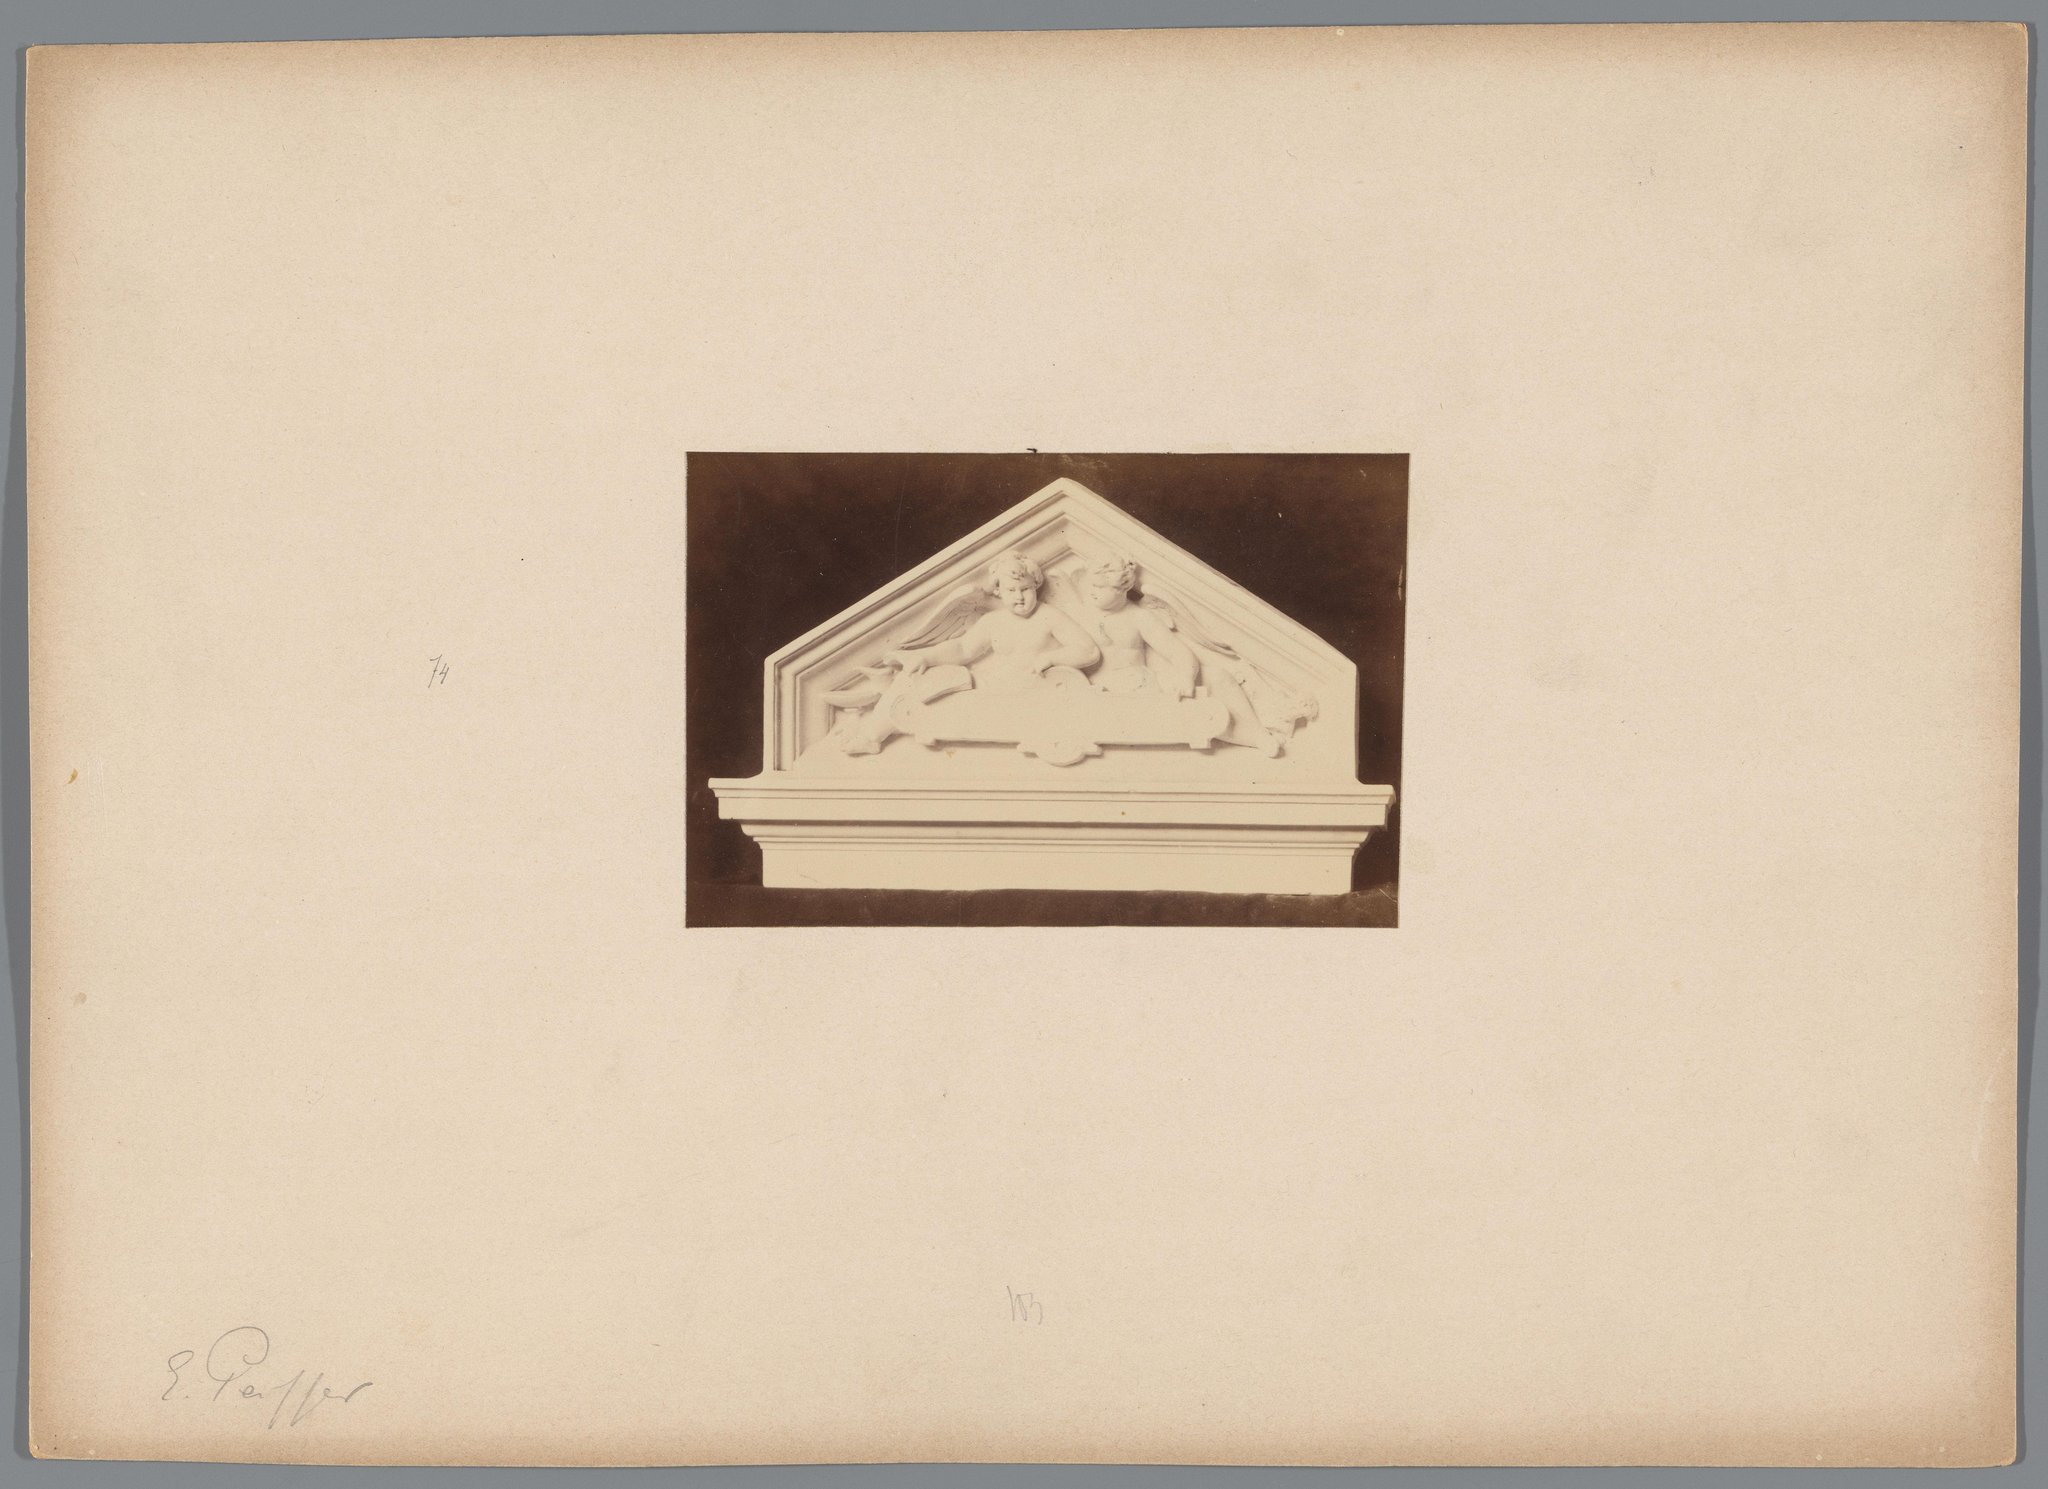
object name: reproduction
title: Modellen van beeldhouwwerken voor een prijsvraag uitgeschreven door het Rijksmuseum Amsterdam, 1880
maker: Anonymous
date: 1880-1887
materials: cardboard, paper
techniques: albumen print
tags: piece of sculpture, reproduction of a piece of sculpture, angels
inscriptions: inscription: ‘103/ 74’, inscription: ‘E. Pfeiffer’, collector's mark: Lugt 2228